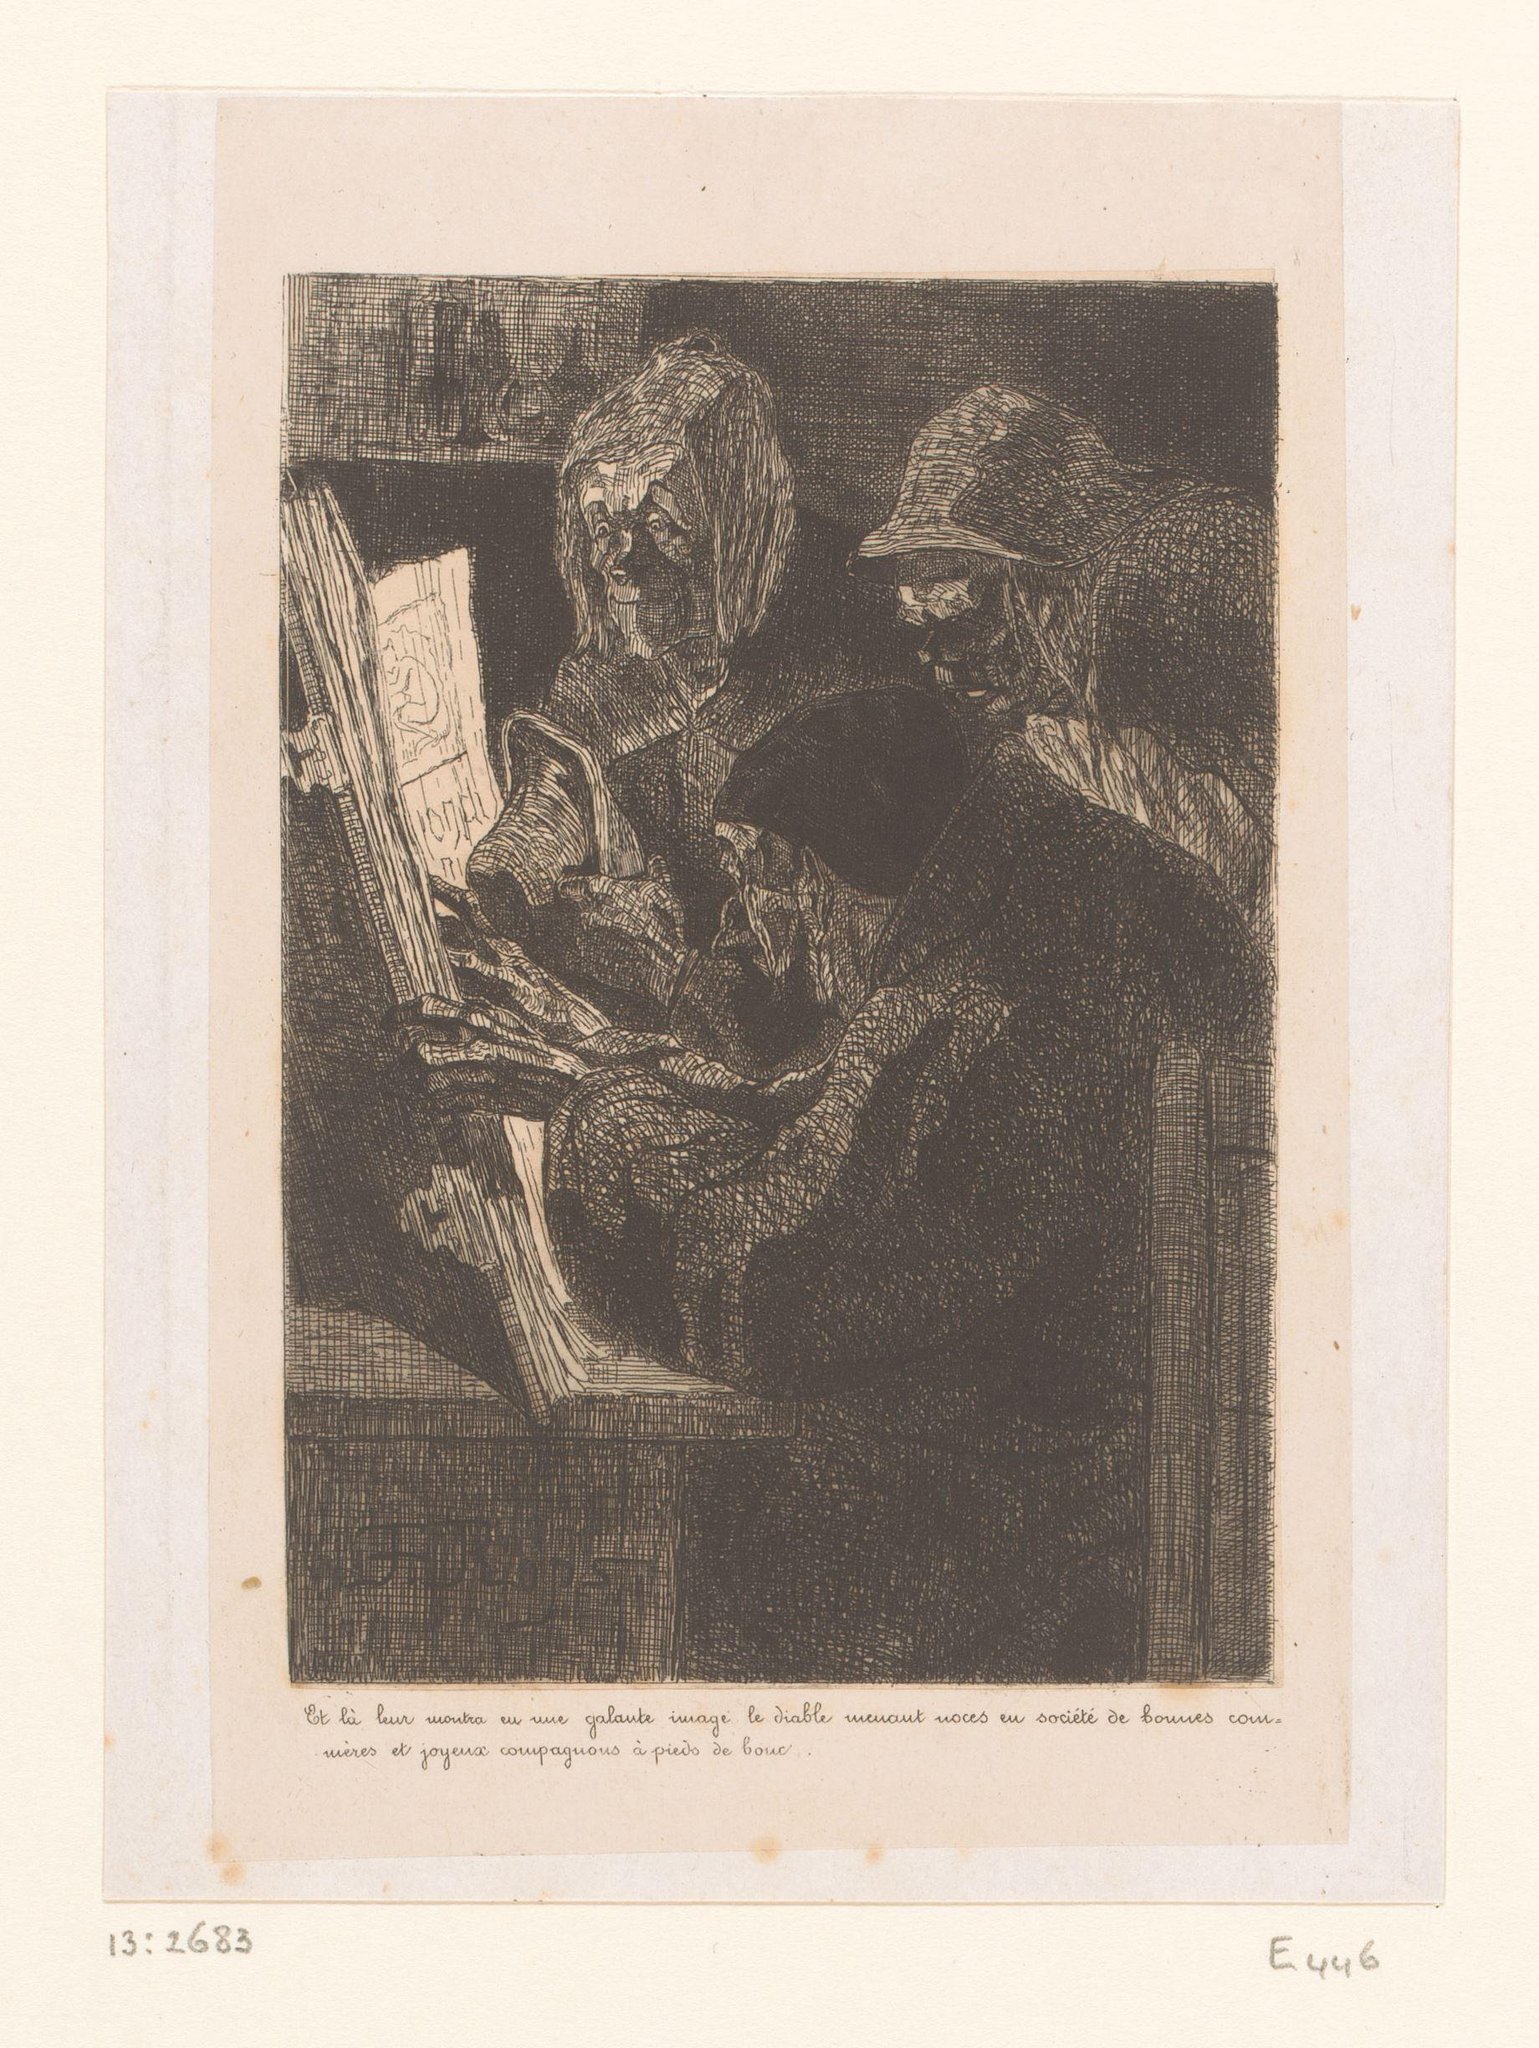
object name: book illustration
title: Les frères de la bonne trogne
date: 1858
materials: paper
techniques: etching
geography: paris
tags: book - mm - book open, debate, discussion (~ meeting)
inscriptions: collector's mark: Lugt 2228, collector's mark: Lugt 1485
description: Prent uit: Coster, Charles de. Légendes Flamandes. Parijs: Michel Lévy, 1858.